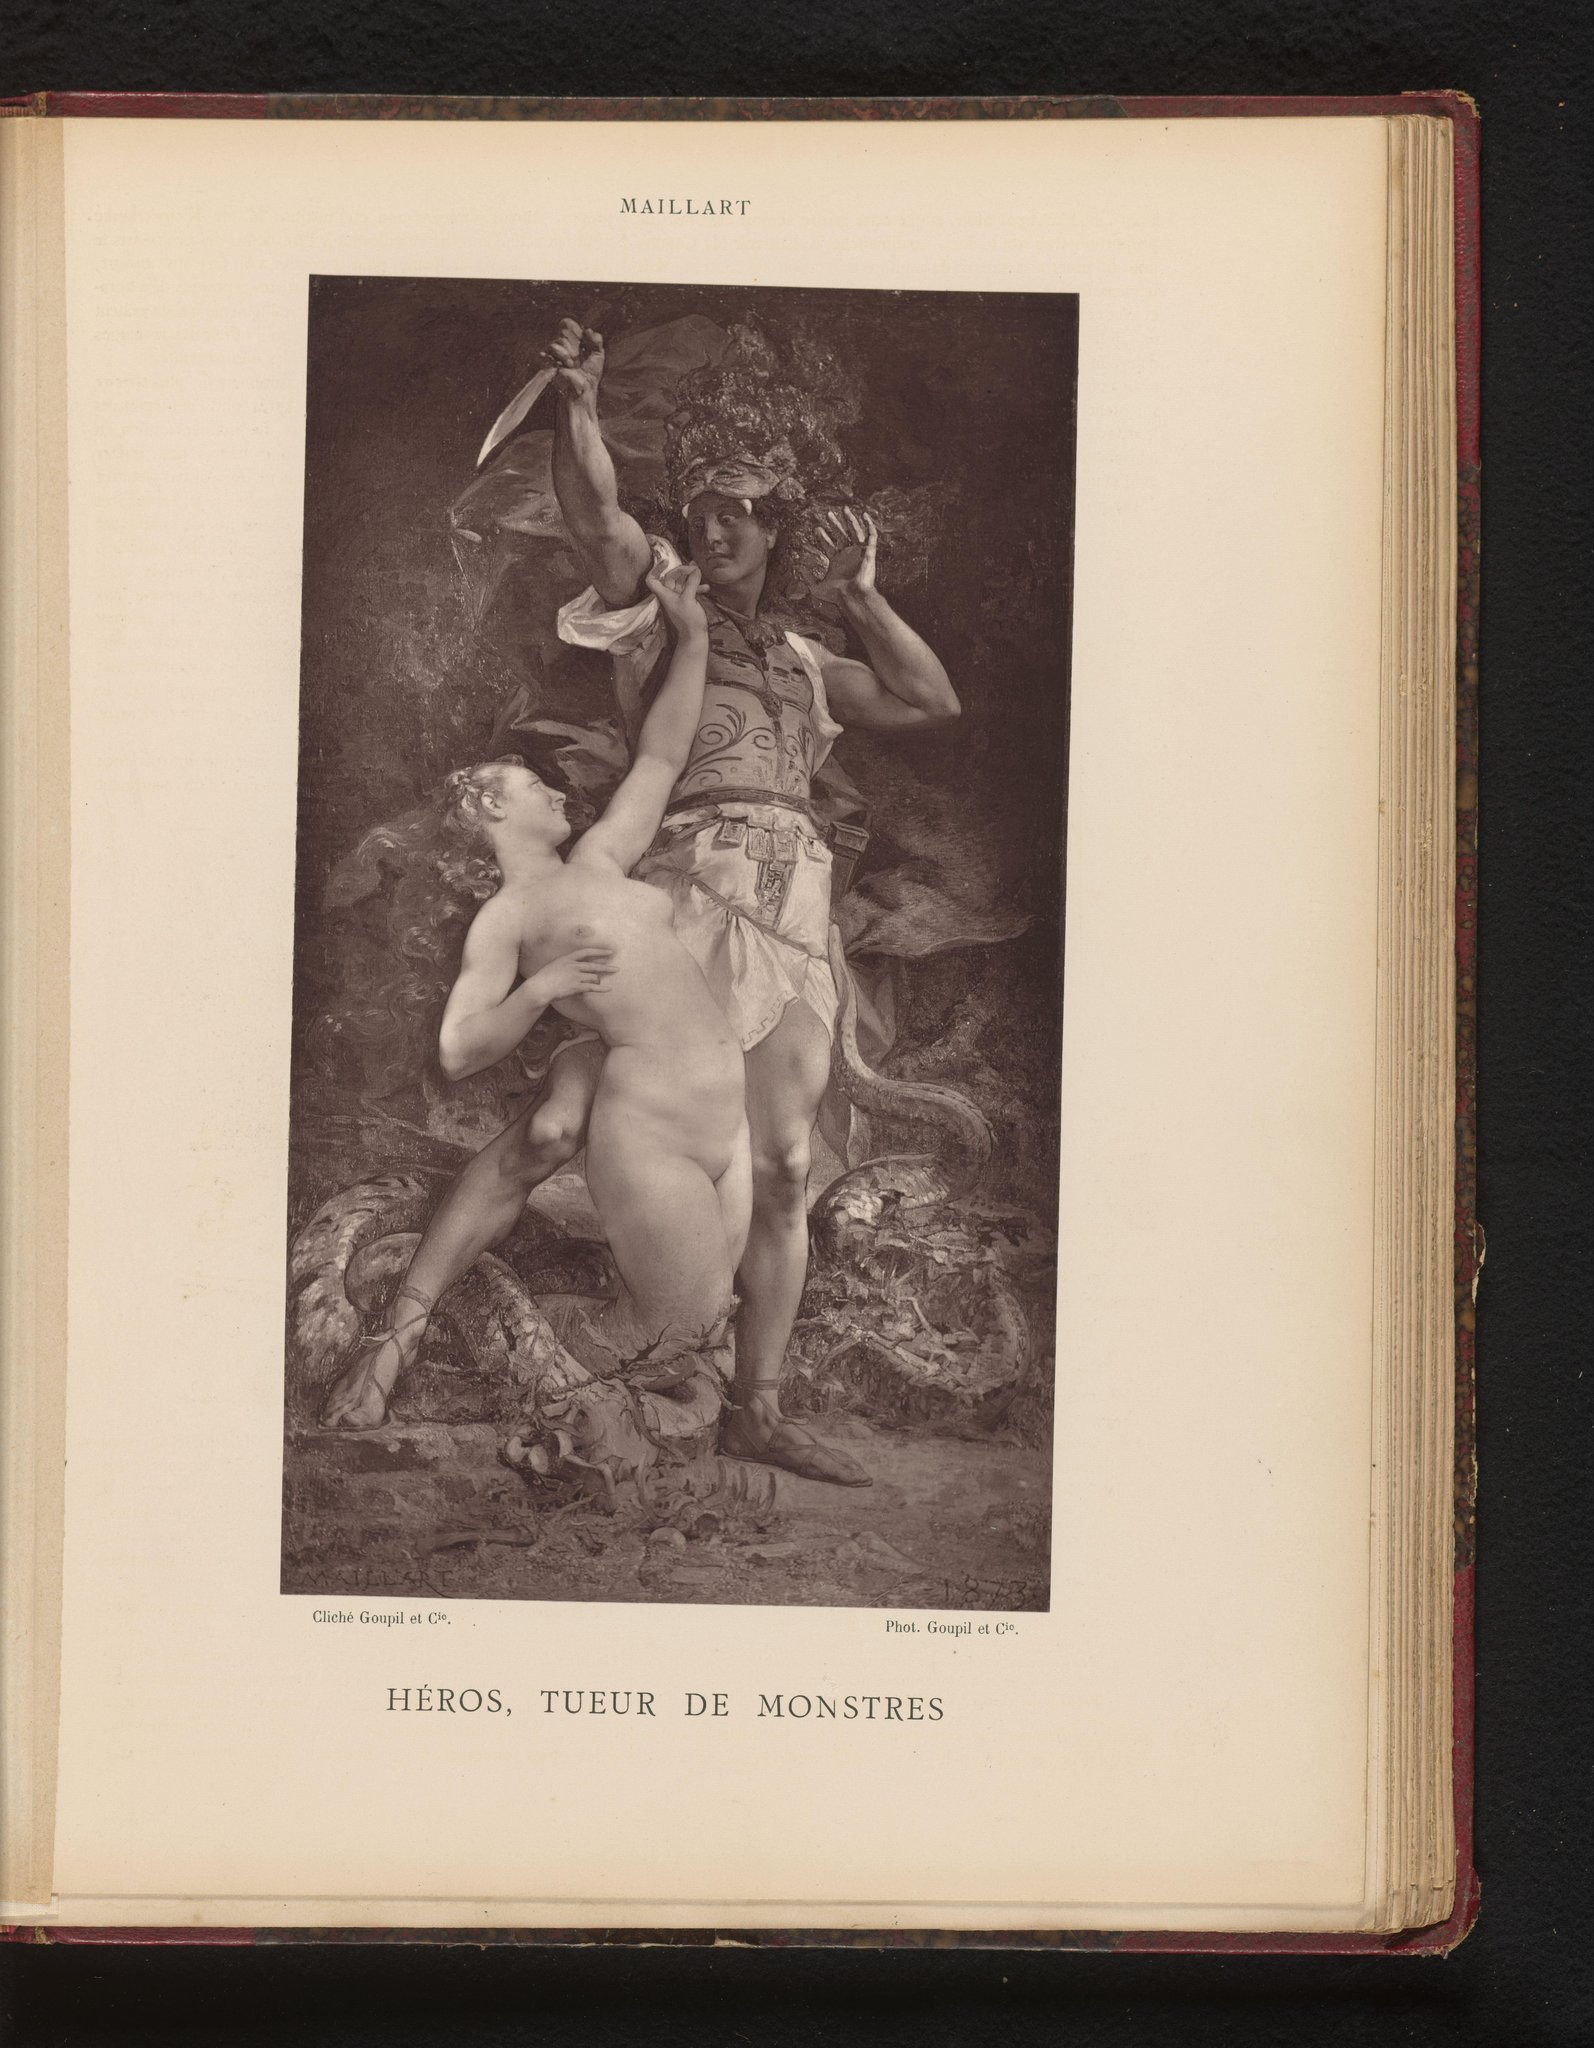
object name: page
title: Fotoreproductie van het schilderij 'Héros, tueur de monstres' door Diogène Maillart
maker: diogène ulysse napoléon maillart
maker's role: draughtsman, painter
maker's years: 1840-1926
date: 1876-1881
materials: paper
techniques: woodburytype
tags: adult man, the (nude) human figure; 'corpo humano' (ripa) - aa - female human figure, fighting